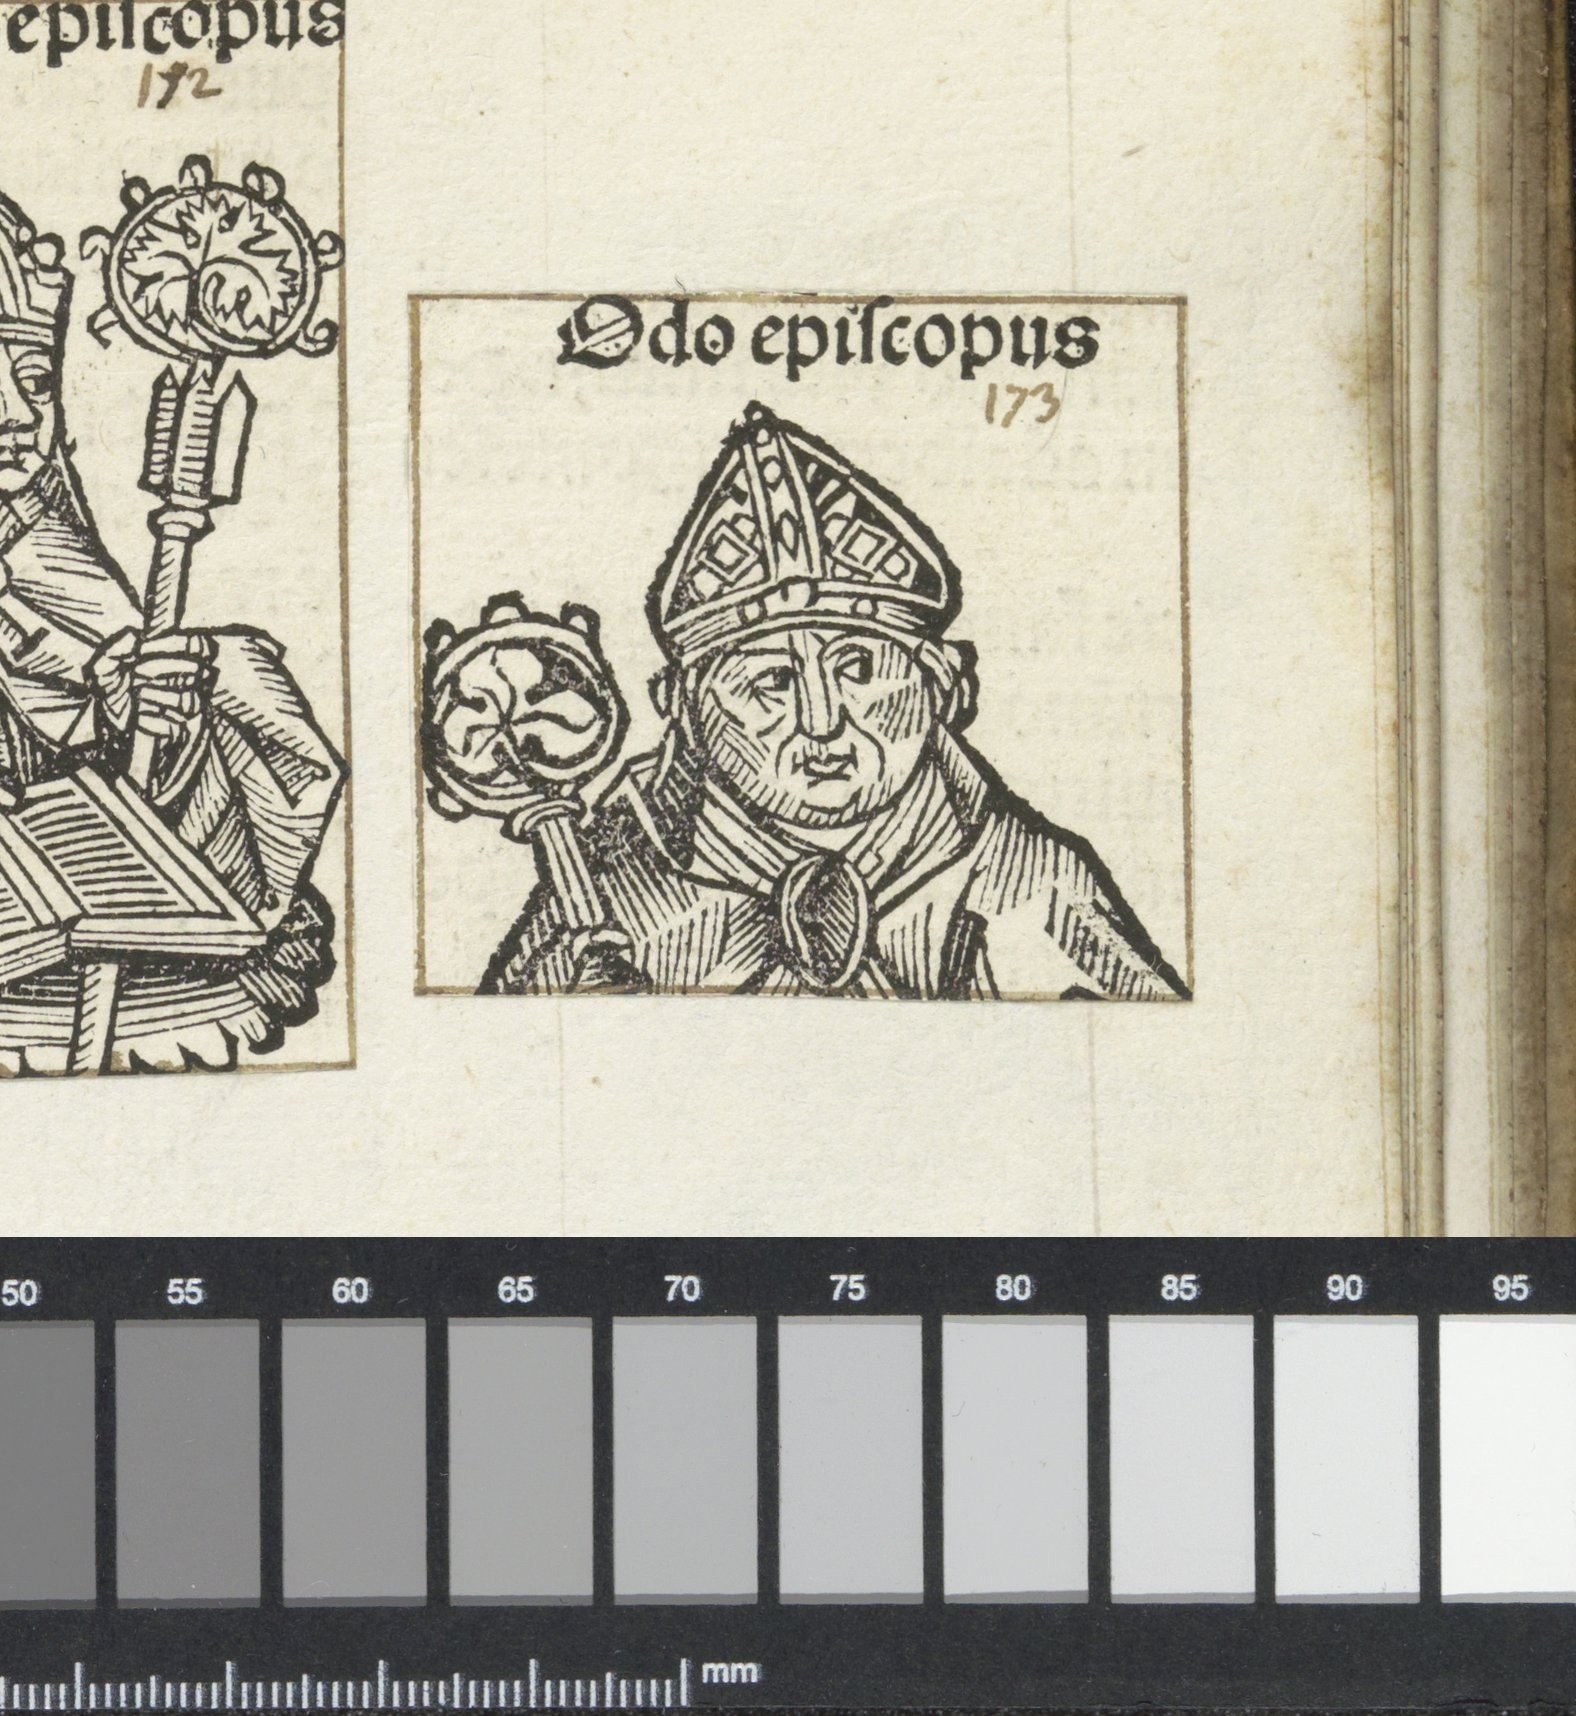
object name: book illustration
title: Odo van Canterbury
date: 1493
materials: paper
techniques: letterpress printing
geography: nuremberg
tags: archbishop, bishop, etc. (roman catholic)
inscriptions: inscription: ‘173’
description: De houtsnede wordt herhaaldelijk gebruikt als boekillustratie in de Liber Chronicarum (of Neurenbergkroniek) van Hartmann Schedel, verschenen in het Latijn en Duits in 1493. Zie de Latijnse uitgave, folio 182v.